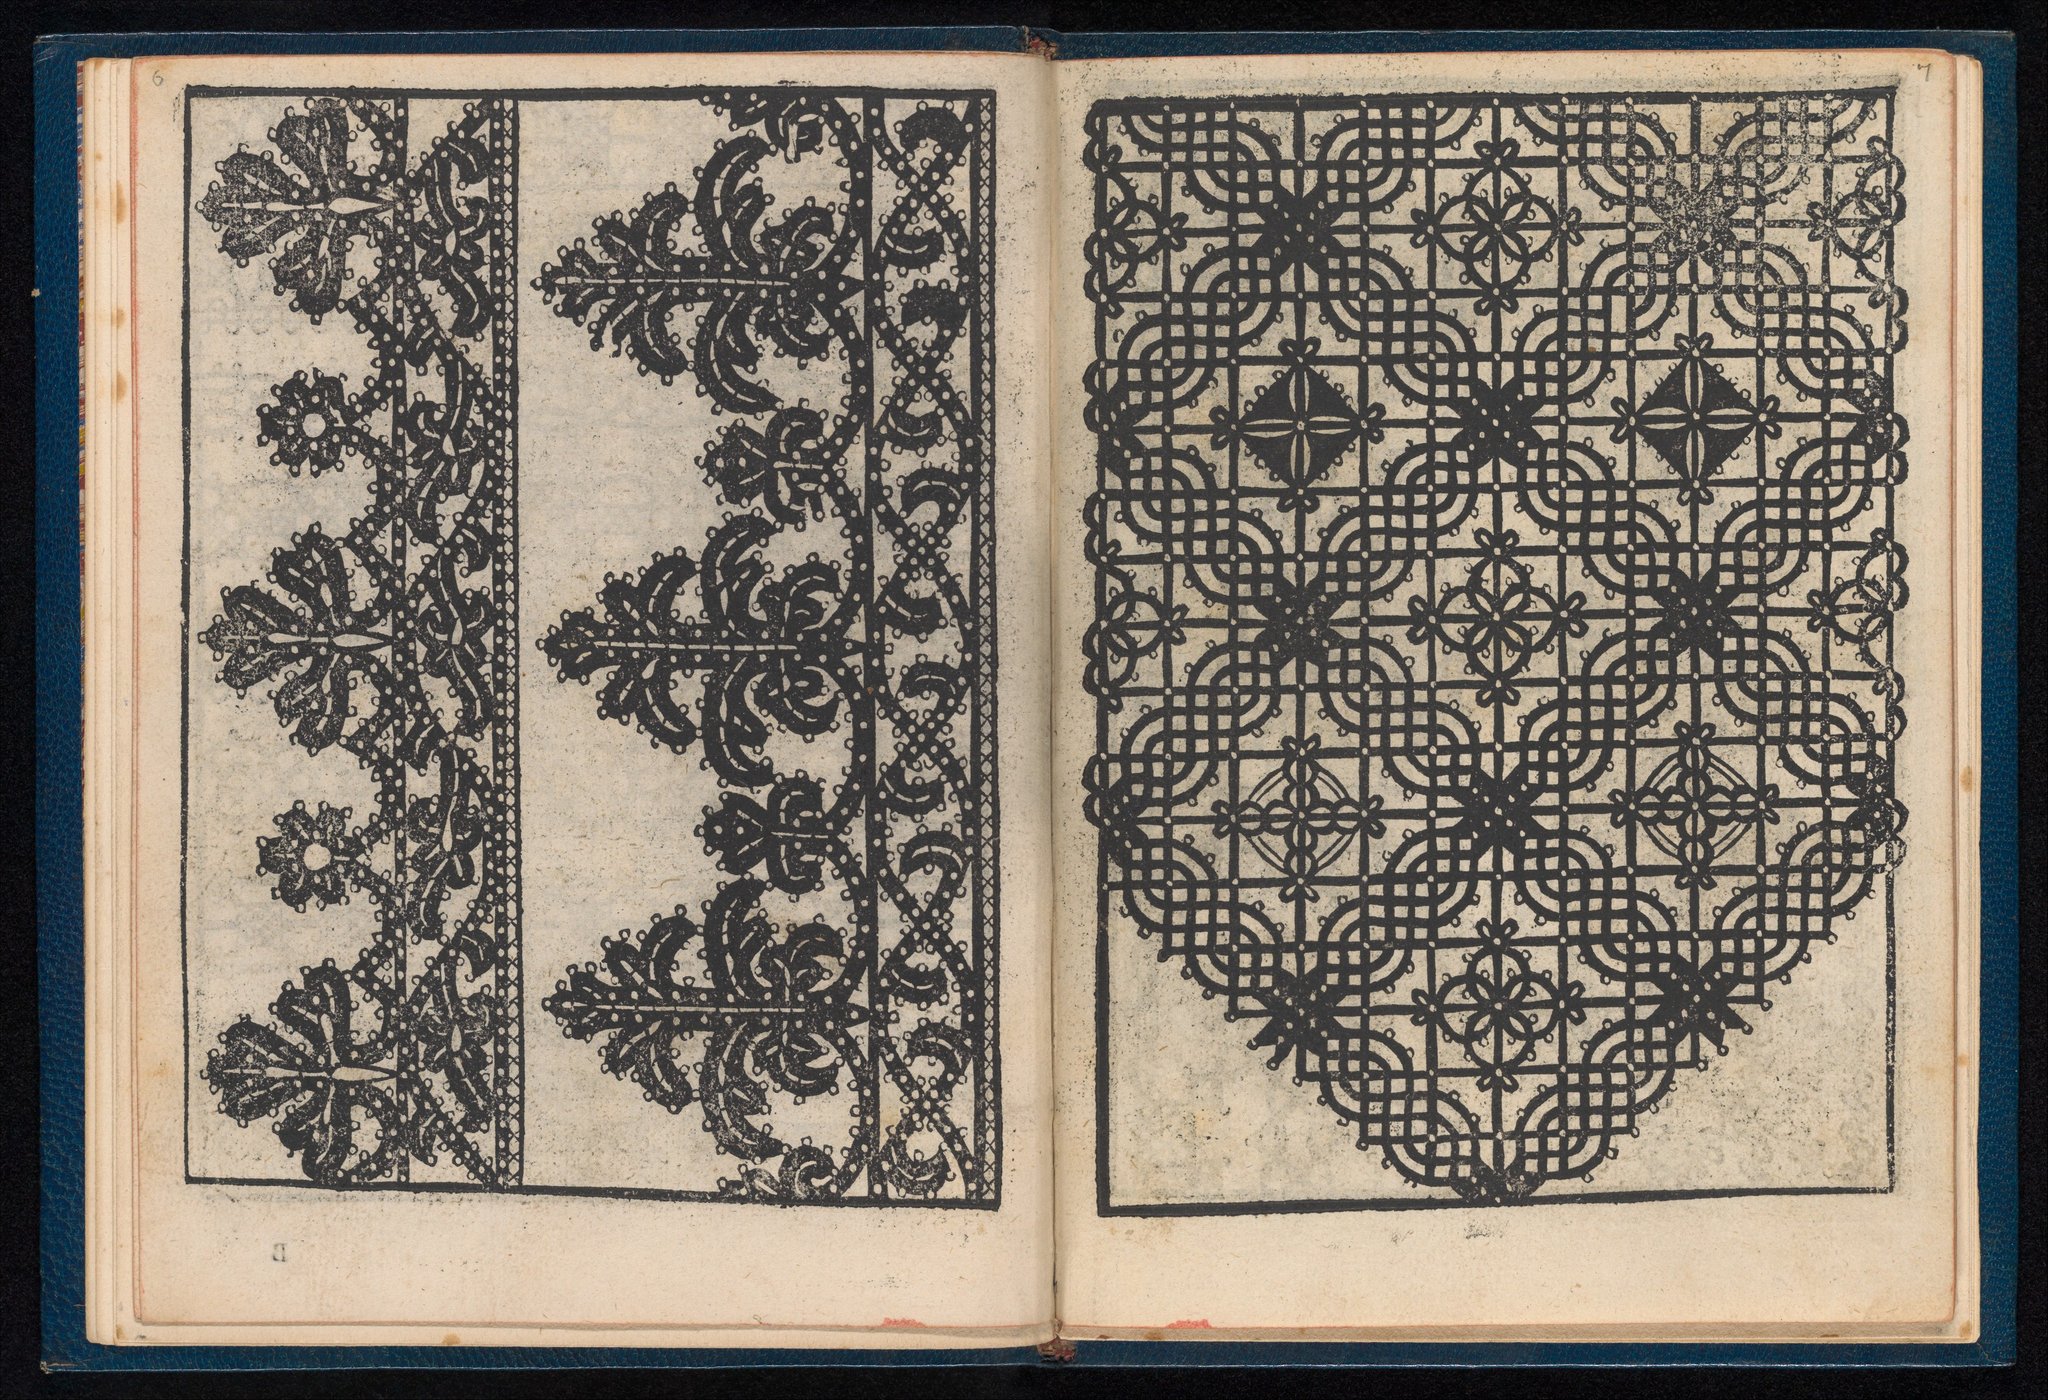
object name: book print ornament architecture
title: Le Pompe: Opera Nova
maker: giovanni battista & marchio sessa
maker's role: publisher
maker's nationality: italian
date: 1557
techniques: woodcut